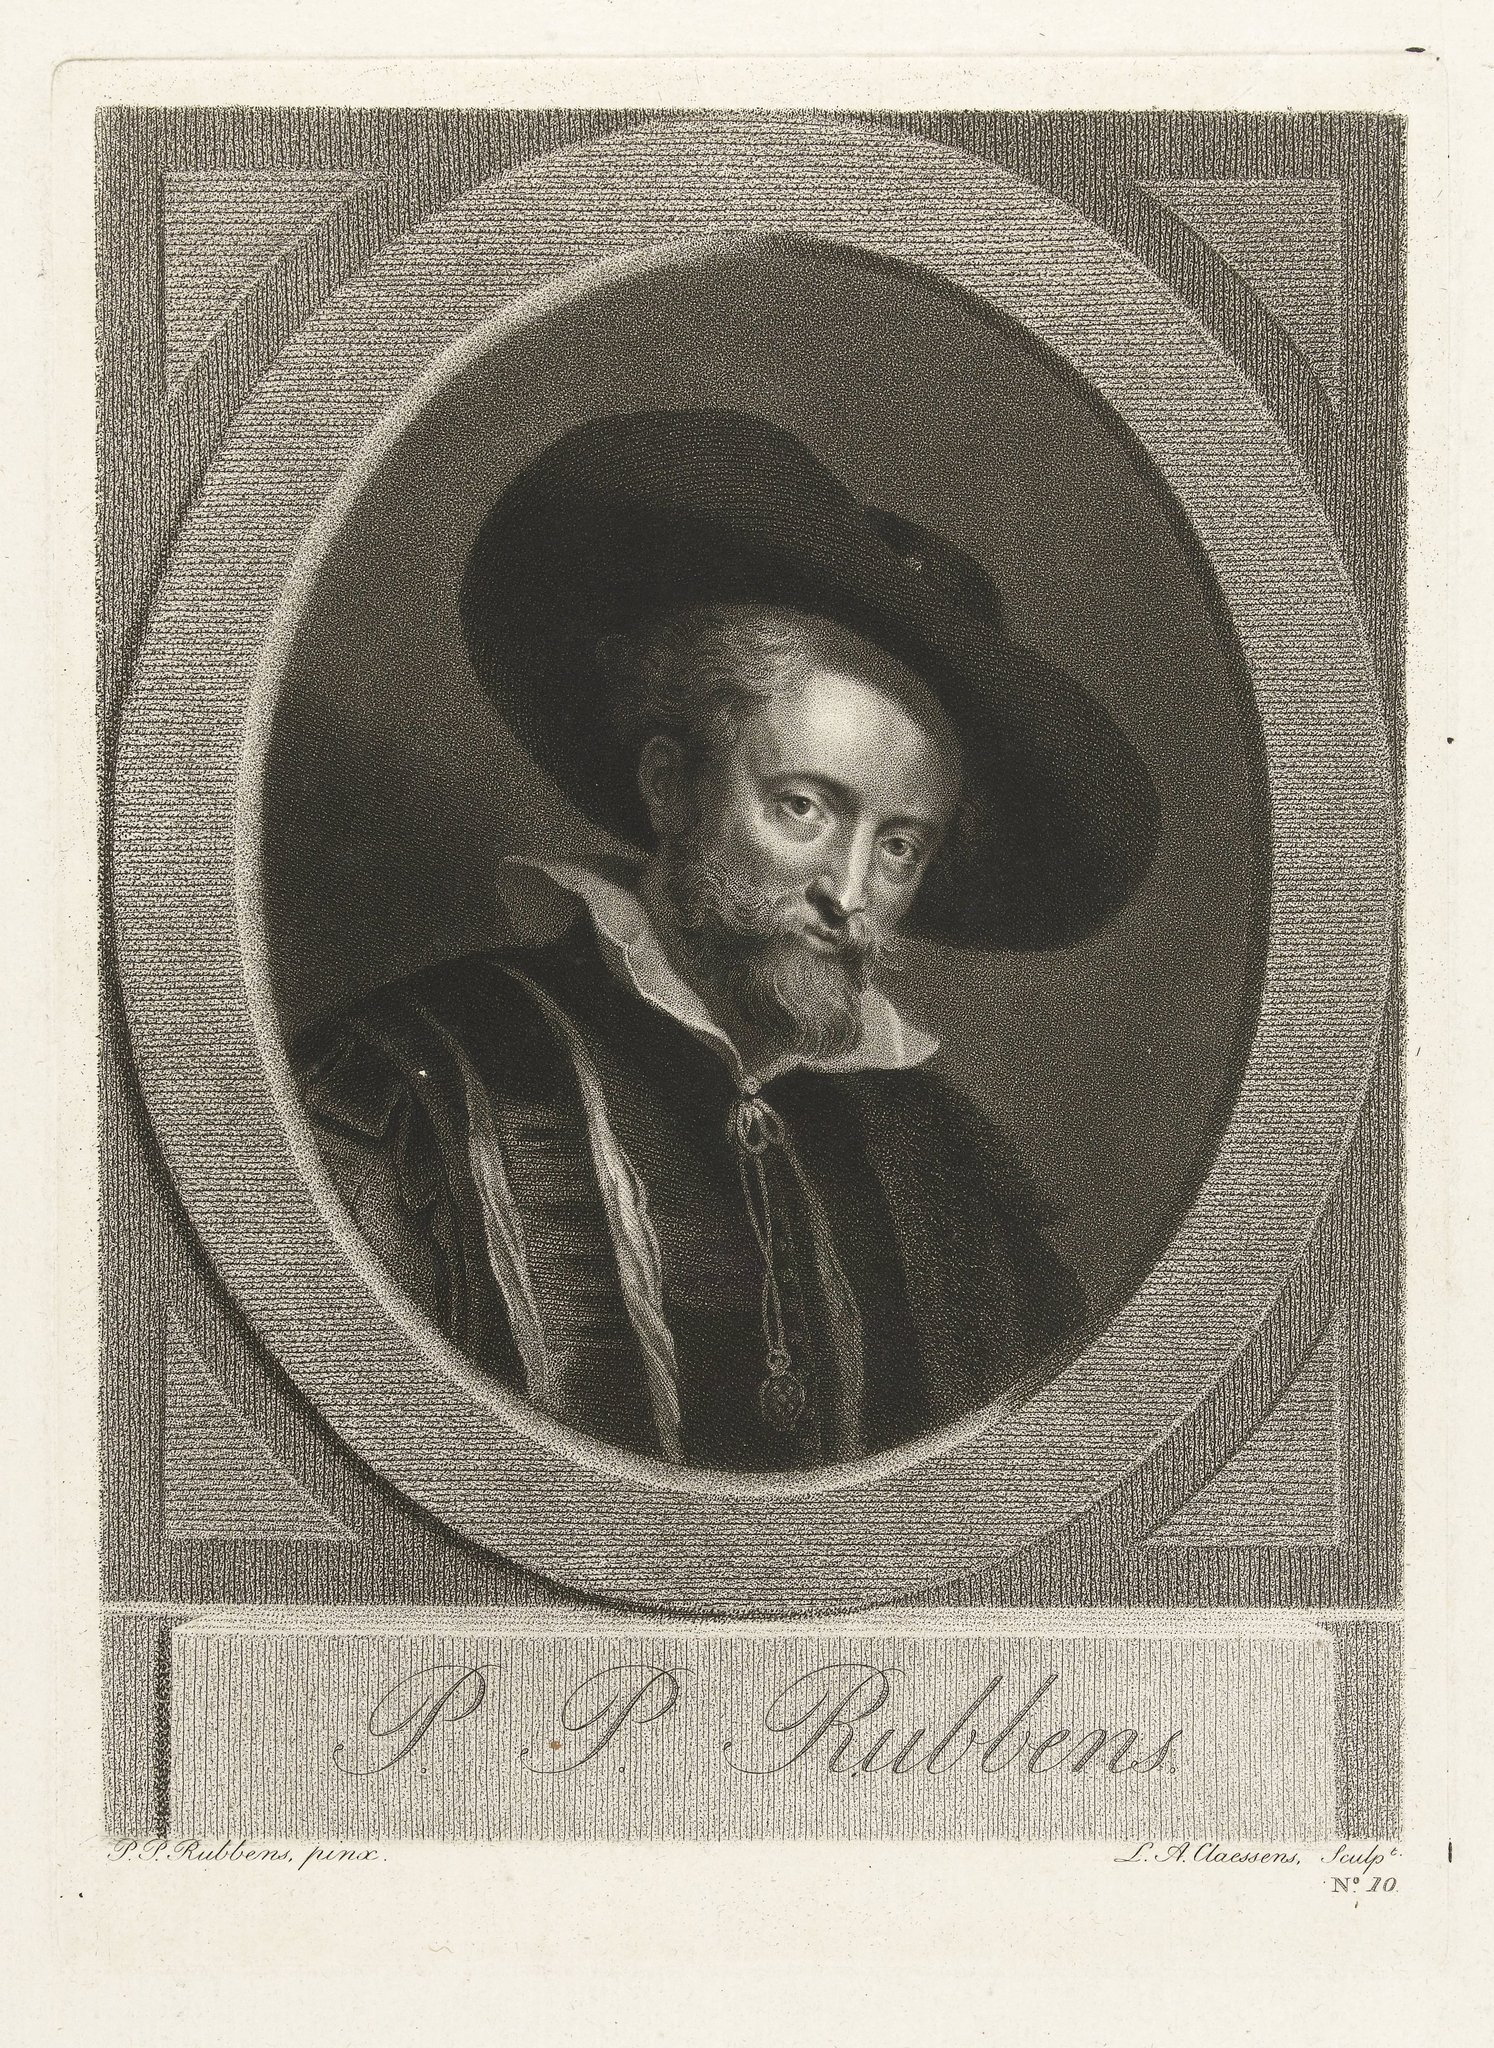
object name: print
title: Zelfportret van Peter Paul Rubens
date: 1829-1834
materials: paper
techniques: engraving, etching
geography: paris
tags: antwerp, painter, print maker, draughtsman, peter paul rubens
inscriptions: collector's mark: Lugt 2228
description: Gemaakt voor: Musée français : recueil des plus beaux tableaux, statues et bas-reliefs qui existaient au Louvre avant 1815, avec l'explication des sujets, et des discours historiques sur la peinture, la sculpture et la gravure. Paris: A. & W. Galignani & Londers, J.O. Robinson, [1829-39]